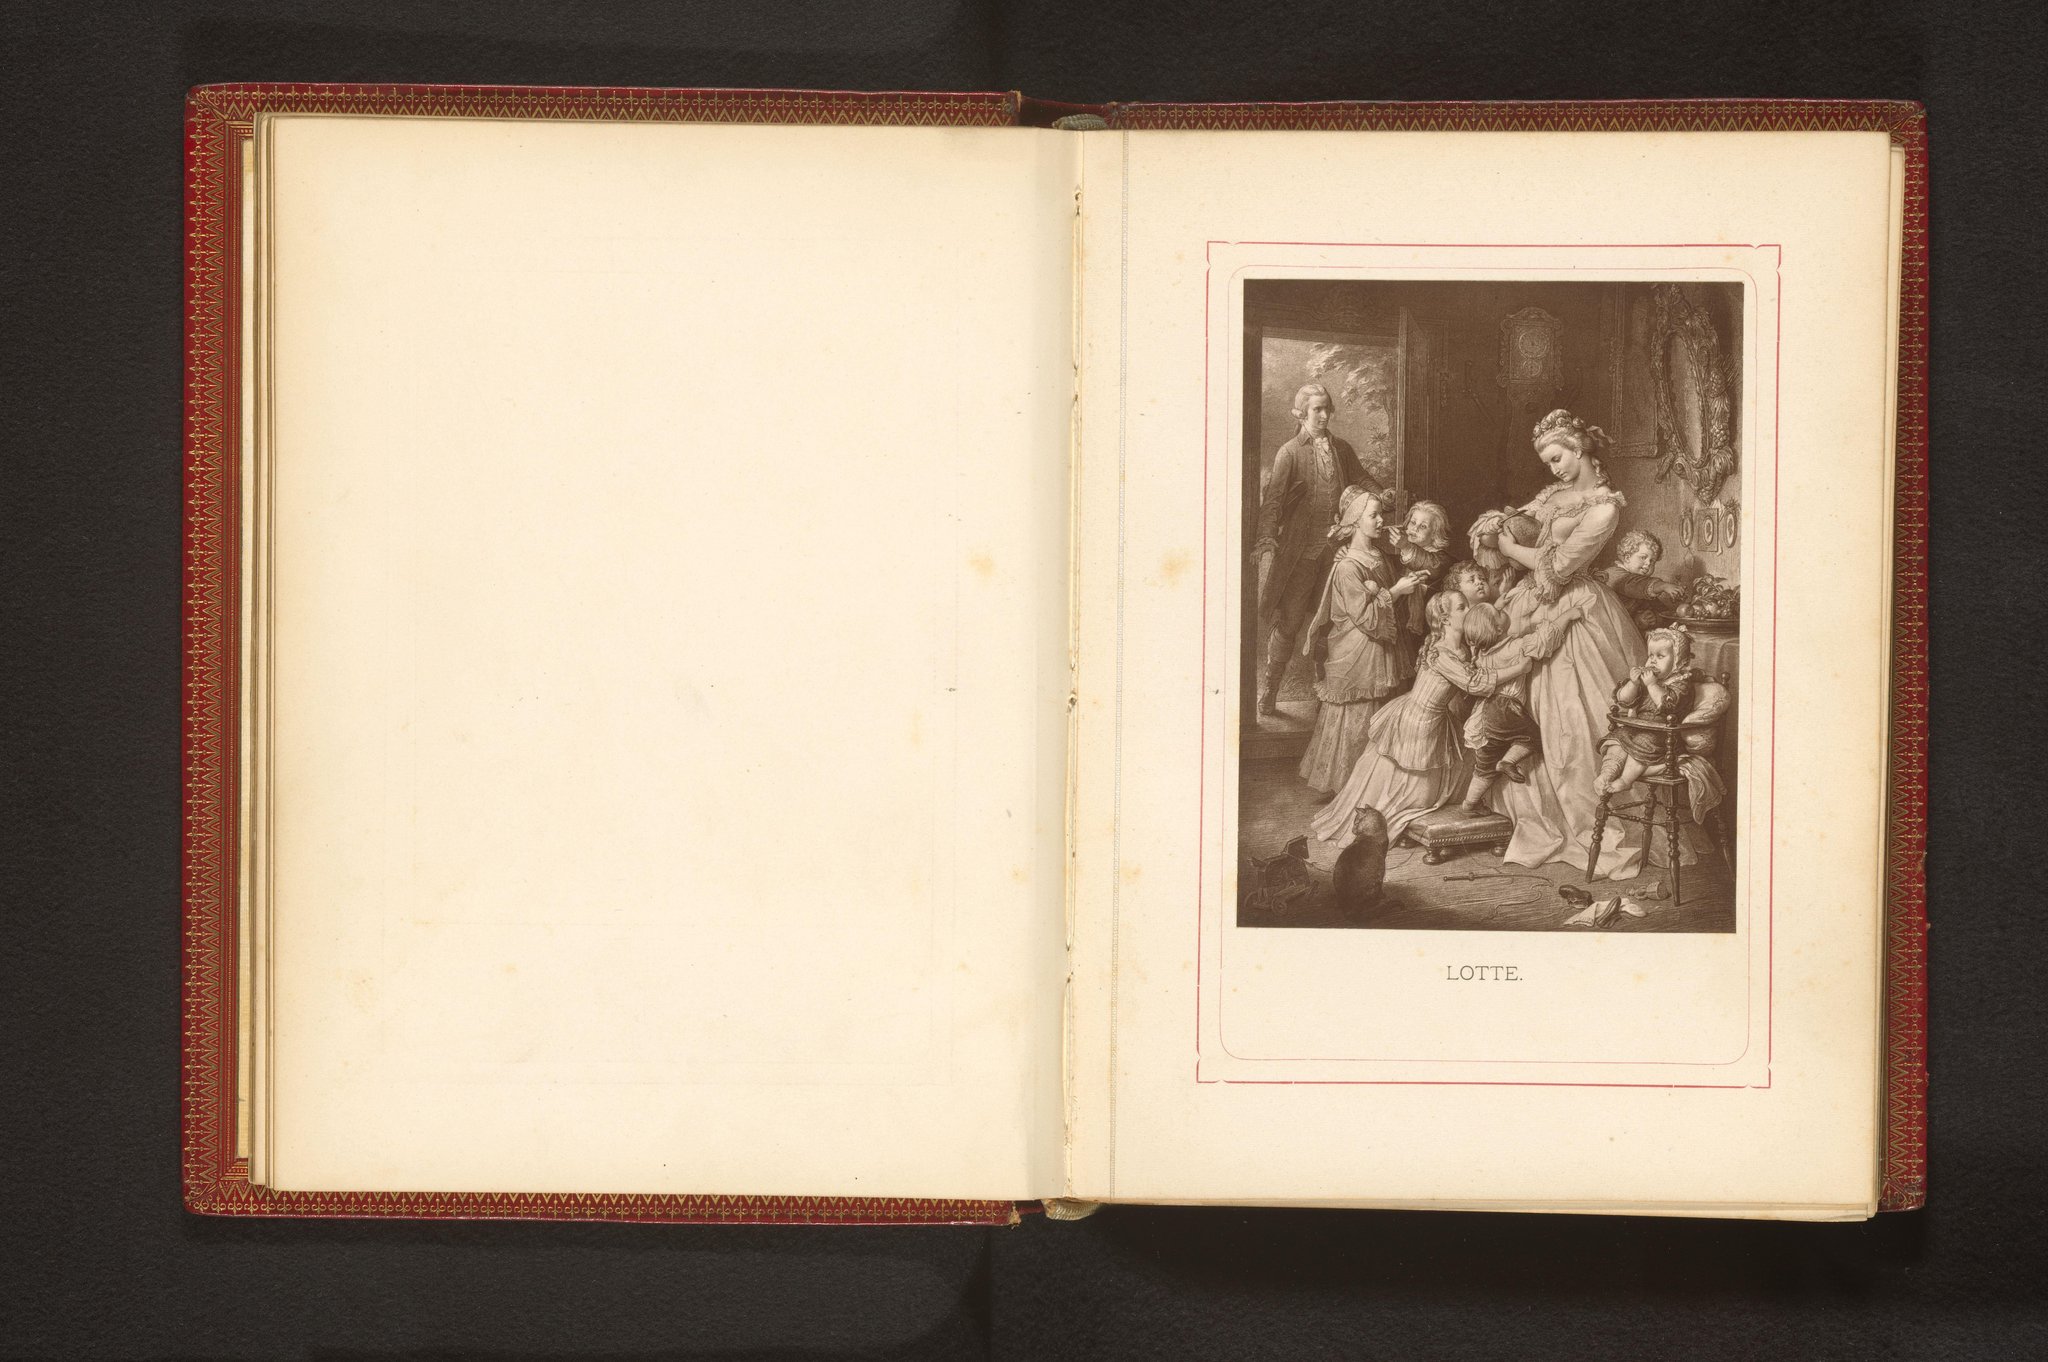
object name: photomechanical print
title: Lotte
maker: Anonymous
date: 1875-1885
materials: paper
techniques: photograph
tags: brothers or sisters (second degree family relationships), (scenes from) specific works of literature: goethe, werther